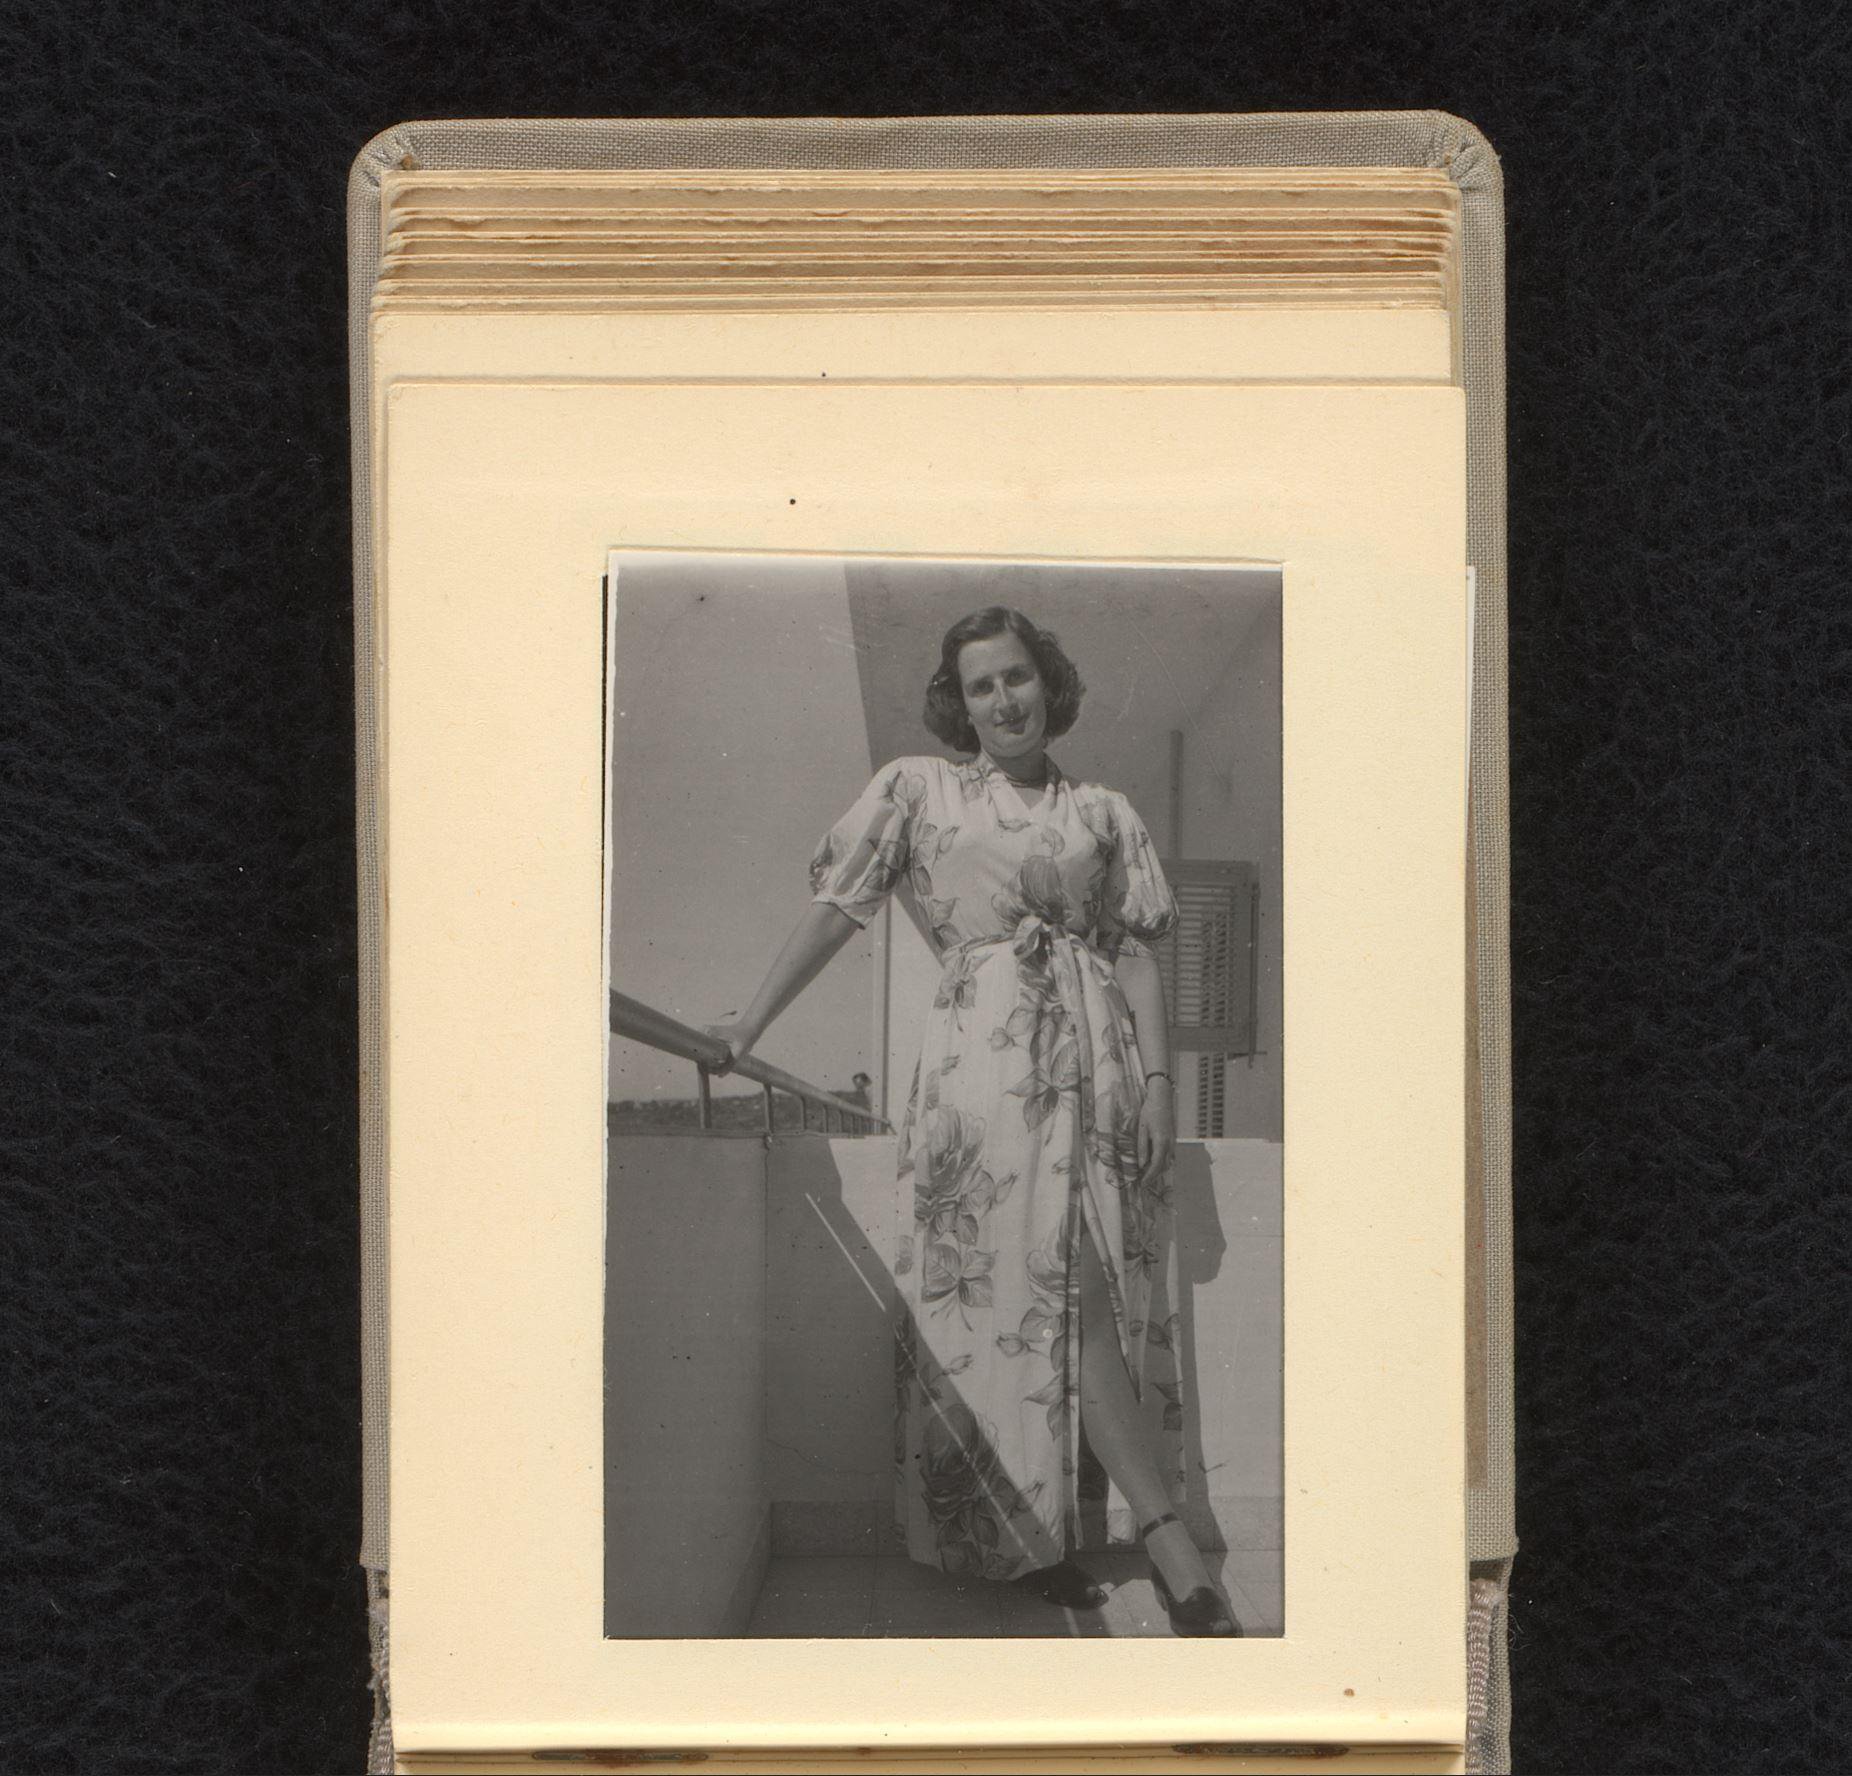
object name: album leaf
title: Isabel Wachenheimer in bloemetjesjapon op het balkon, 1947-1955, Israël / Man achter stuur van auto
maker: isabel wachenheimer-elon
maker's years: 1928-2010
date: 1947-1955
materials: paper, photographic support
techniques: gelatin silver print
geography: israel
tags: leiden, isabel wachenheimer-elon, historical persons - bb - woman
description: Albumblad bevat twee foto's: Isabel Wachenheimer in bloemetjesjurk op balkon en foto van een man achter de stuur van een auto. Onderdeel van het fotoalbum met diverse foto's van de jeugd van Isabel Wachenheimer voor en tijdens de oorlog en diverse momenten van haar volwassen leven na de Tweede Wereldoorlog.